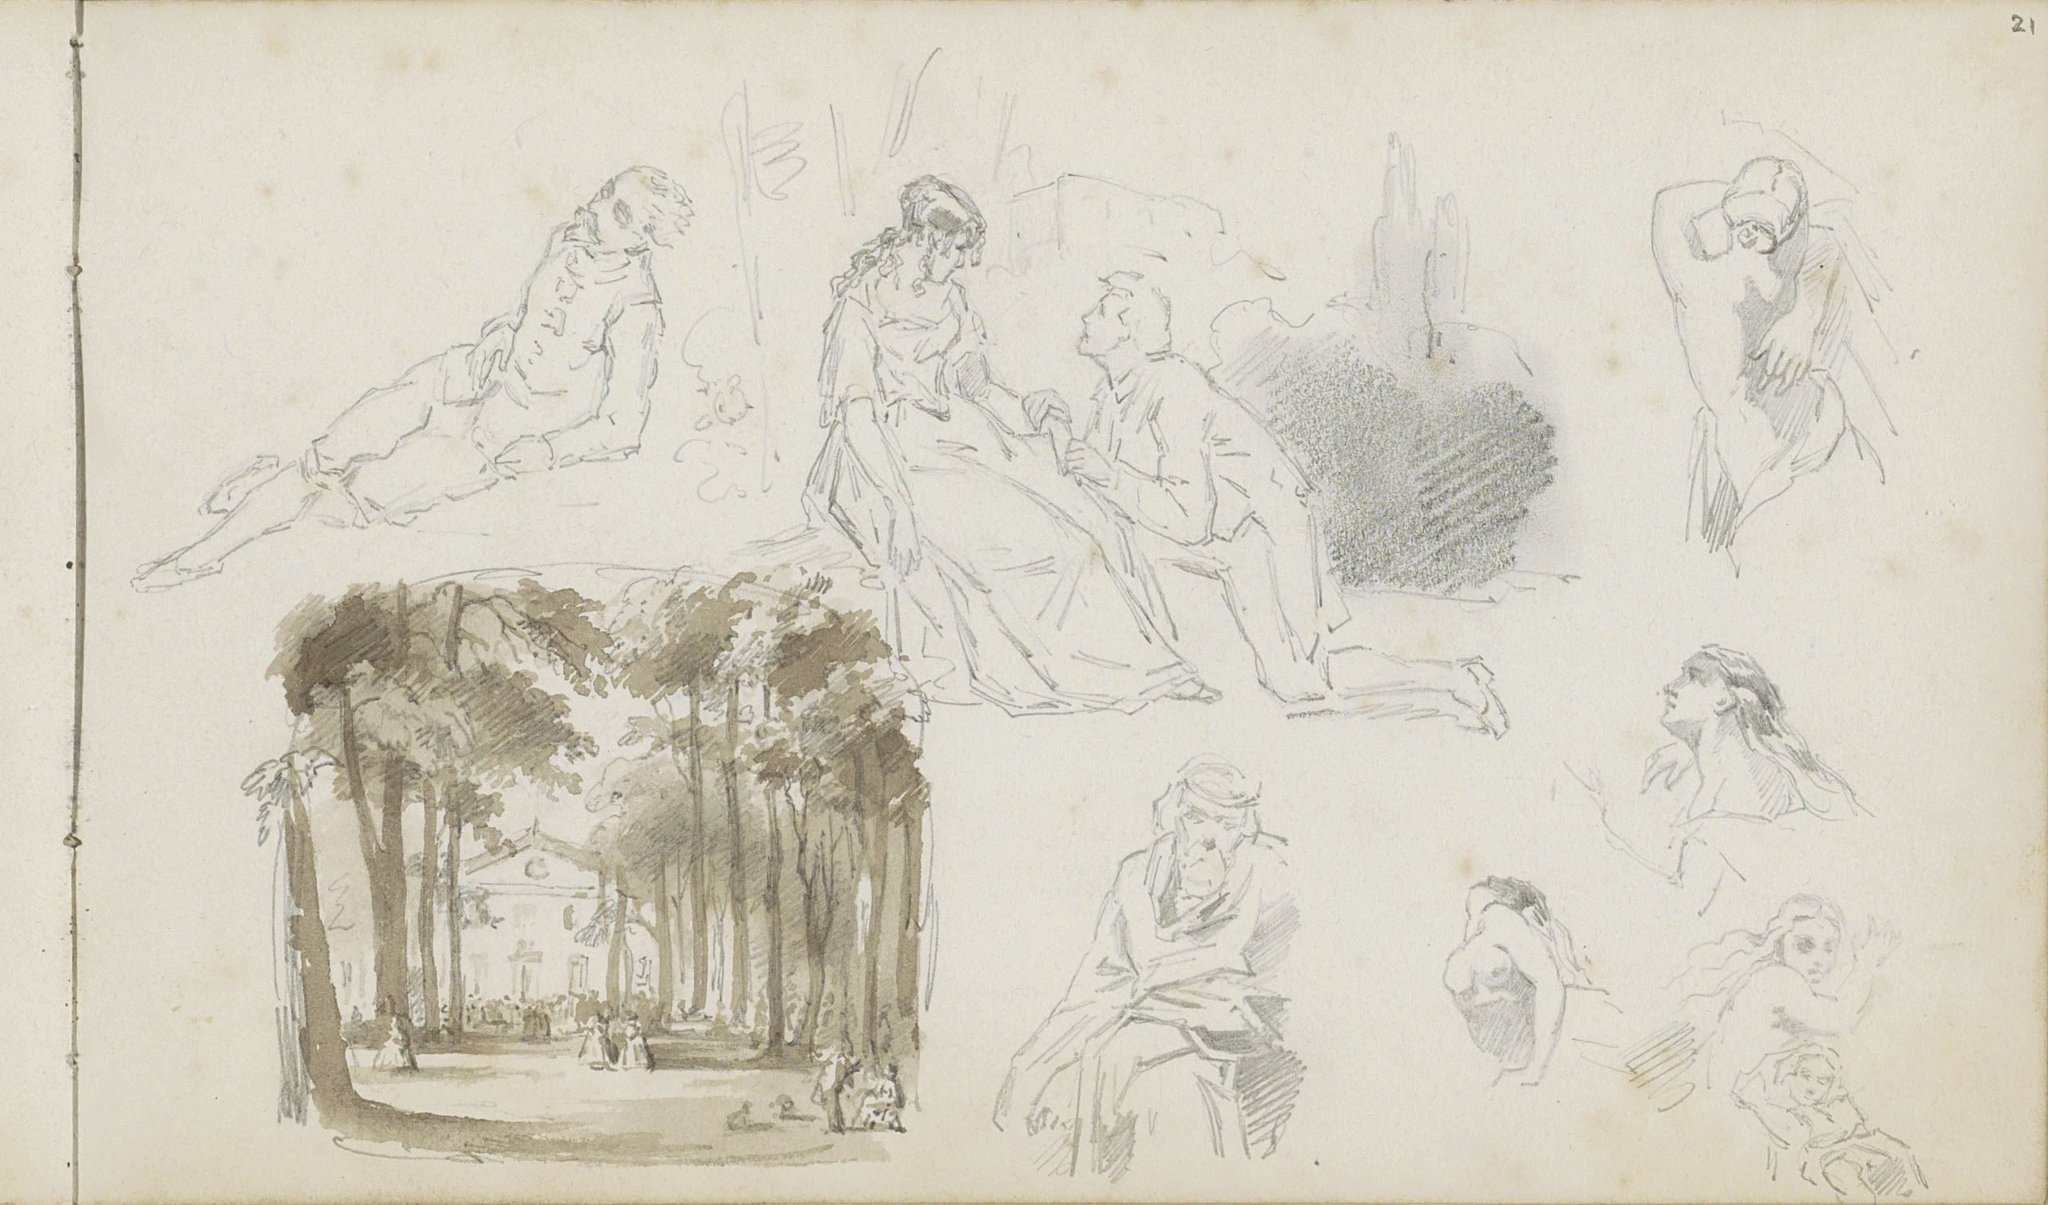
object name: sketchbook leaf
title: Studieblad met (naakte) figuren en de oprijlaan van een landhuis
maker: charles rochussen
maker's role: draughtsman, painter, print maker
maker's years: 1814-1894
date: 1840-1860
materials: paper, pencil, watercolor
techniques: brush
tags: the (nude) human figure; 'corpo humano' (ripa) - aa - female human figure, garden approach, garden drive, couple of lovers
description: Op de oprijlaan en voor het huis staan groepen figuren. Blad 21 recto uit een schetsboek met 38 bladen.